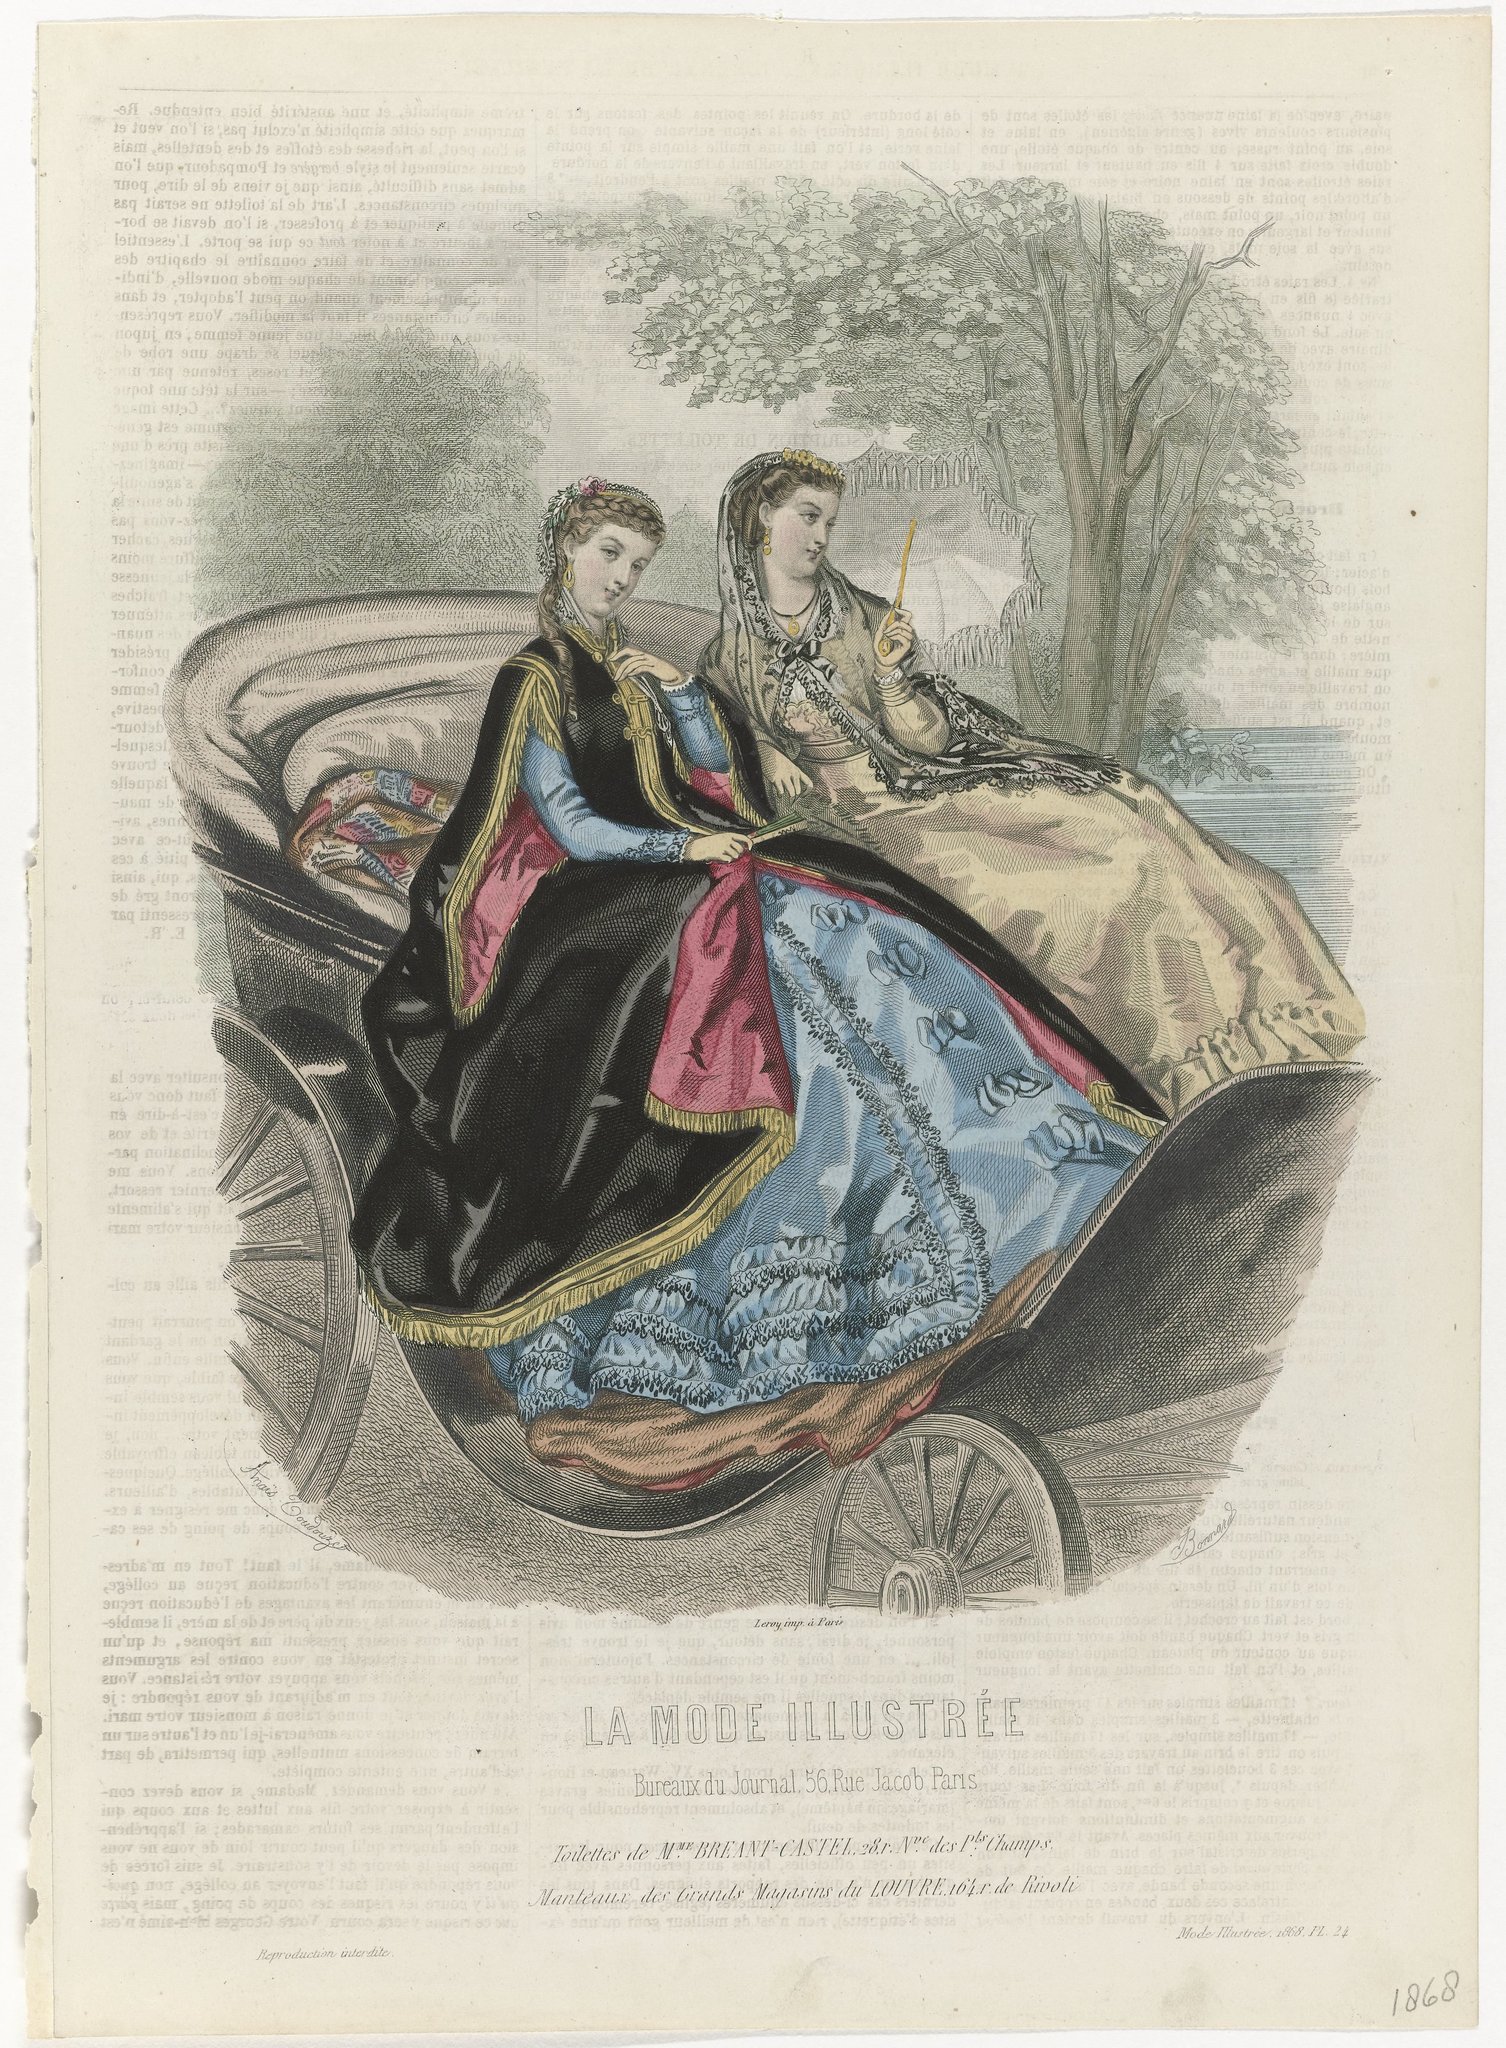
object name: fashion print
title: La Mode Illustrée, 1868, No. 24: Toilettes de Mme Breant-Castel (...)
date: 1868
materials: paper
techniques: engraving, hand coloring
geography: paris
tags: ear-rings (+ women's clothes), pendant, trinket, 'breloque' (+ women's clothes), coat (+ women's clothes), head-gear (+ women's clothes), four-wheeled, animal-drawn vehicle, e.g.: cab, carriage, coach, fashion plates, gloves, mittens, etc. (+ women's clothes), parasol, sunshade (+ women's clothes)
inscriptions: title: ‘La Mode Illustrée’, address: ‘Bureaux du Journal, 56, Rue Jacob. Paris’, caption: ‘Toilettes de M.me Bréant-Castel. 28. r. N.ve des P.ts Champs. Manteau des Grands Magasins du Louvre. 164. r. de Rivoli.’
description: Twee vrouwen, zittend in een open rijtuig. Volgens het onderschrift: ensembles van Breant-Castel. Mantel van 'Grands Magasins du Louvre'. Prent uit het modetijdschrift La Mode Illustrée (1860-1937).